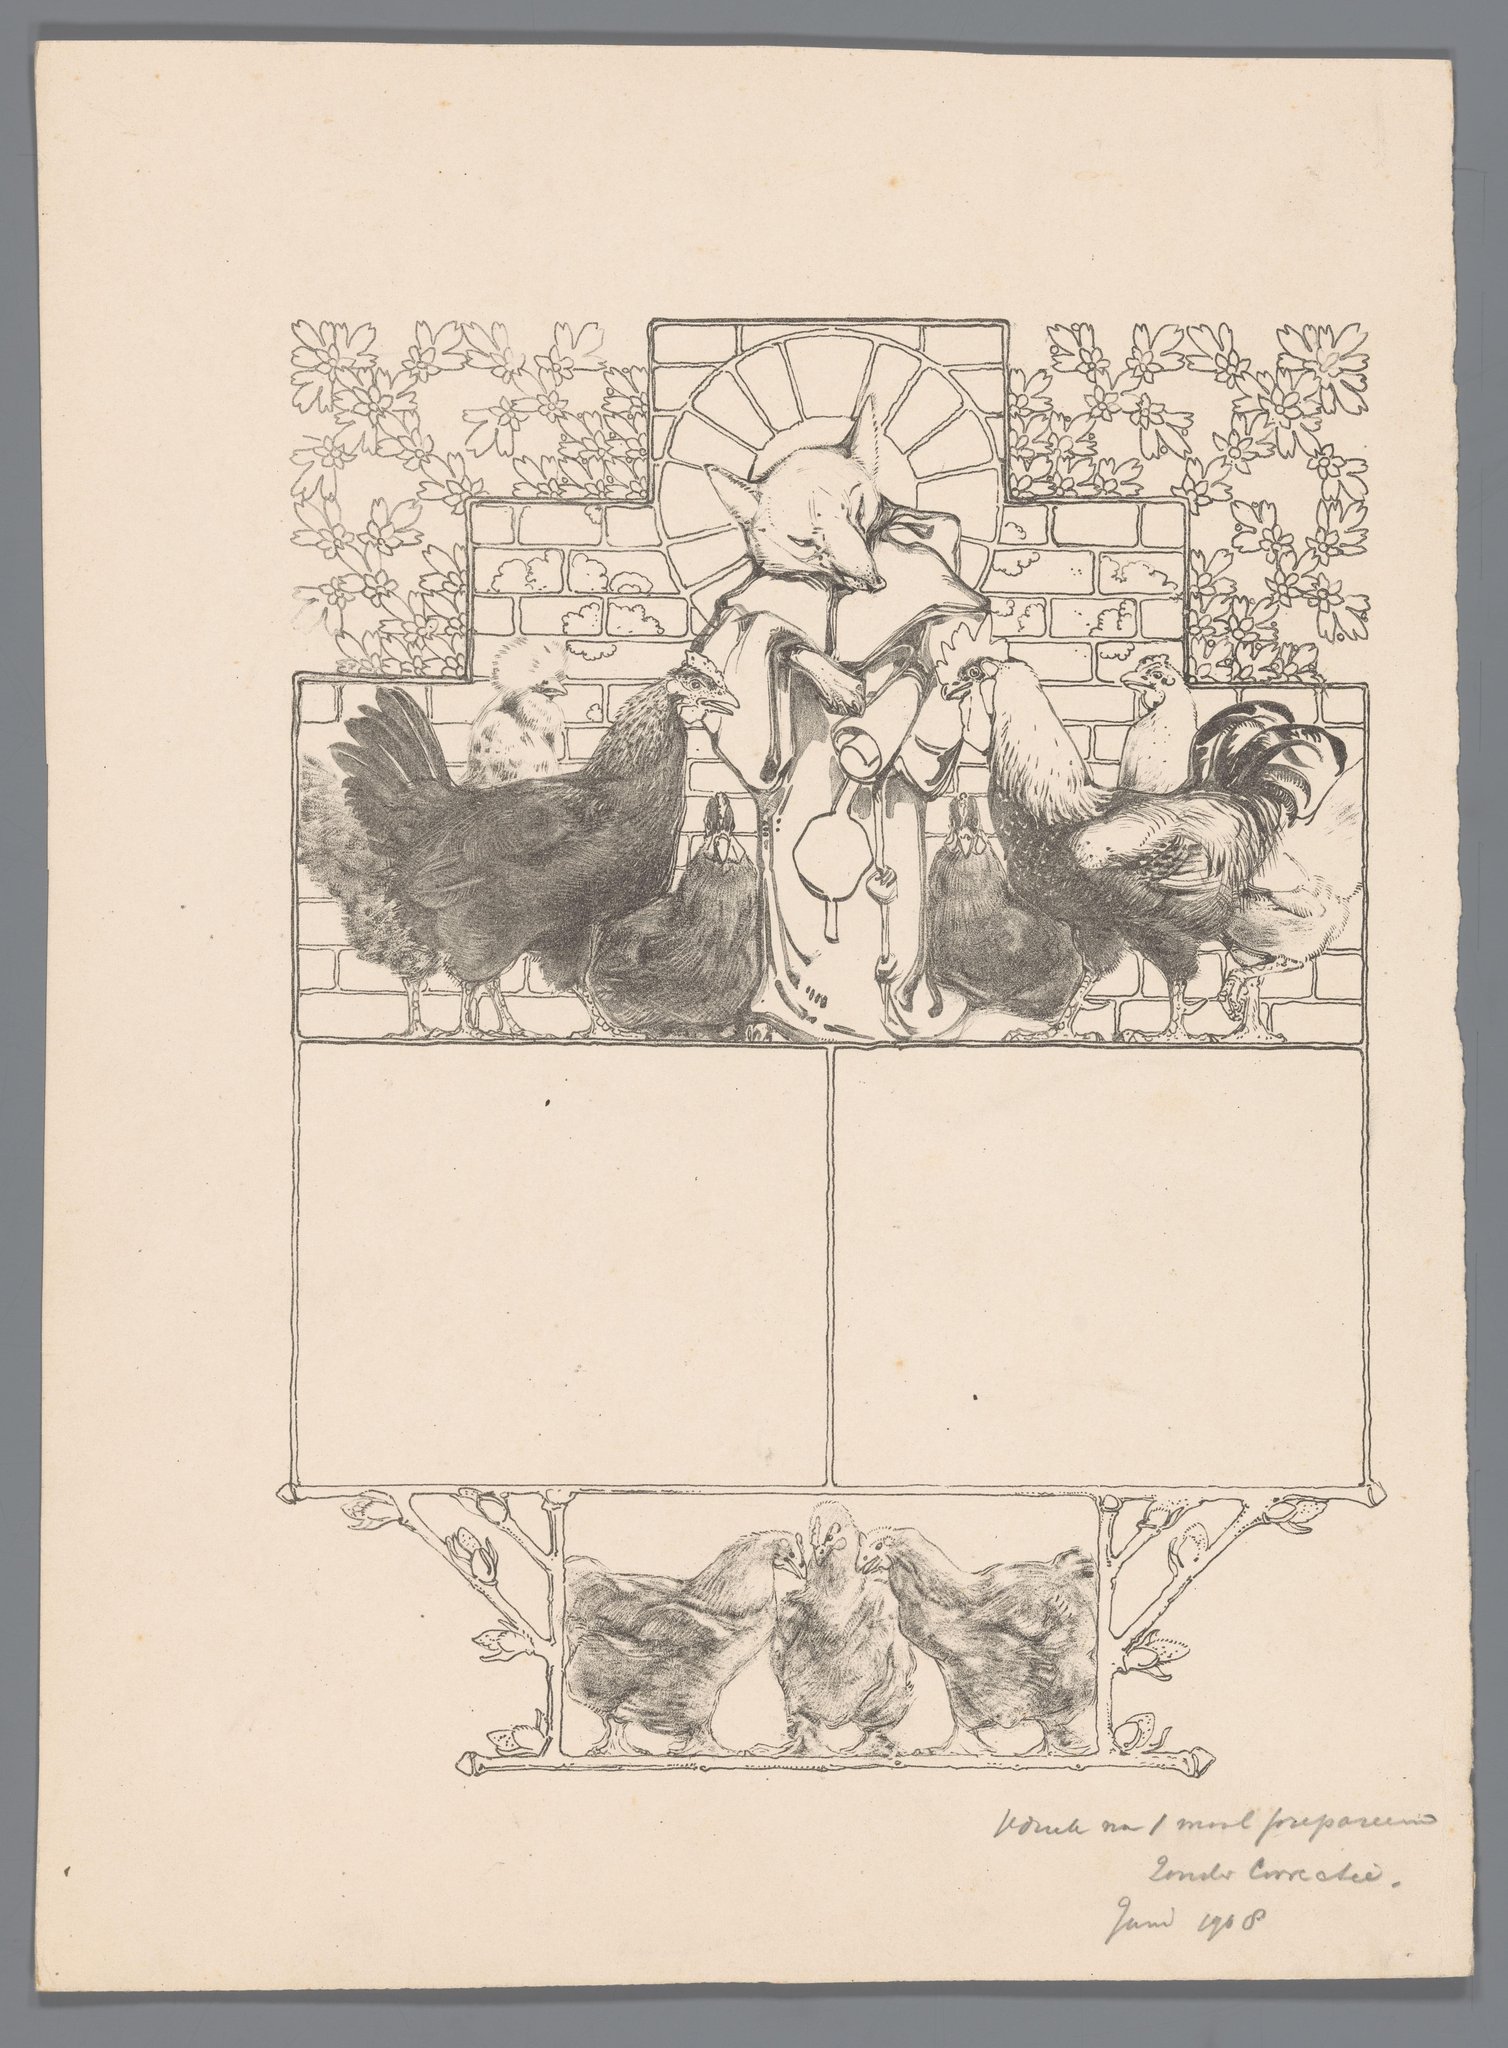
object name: print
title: Vos in monnikspij (Reinaert) omringd door kippen en haan (Cantecleer)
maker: bernard willem wierink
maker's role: draughtsman, print maker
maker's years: 1856-1939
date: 1906-1908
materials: paper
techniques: lithograph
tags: fable of reynard the fox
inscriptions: collector's mark: Lugt 2228, inscription: ‘1e druk na / mool[?] prepareeren[?]/ zonder correctie./ Juni 1908’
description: Ontwerp voor: Streuvels, Stijn (Frank Lateur). Reinaert de Vos naar verschillende uitgaven van het middeleeuwsche epos. Amsterdam: L.J. Veen, 1910.